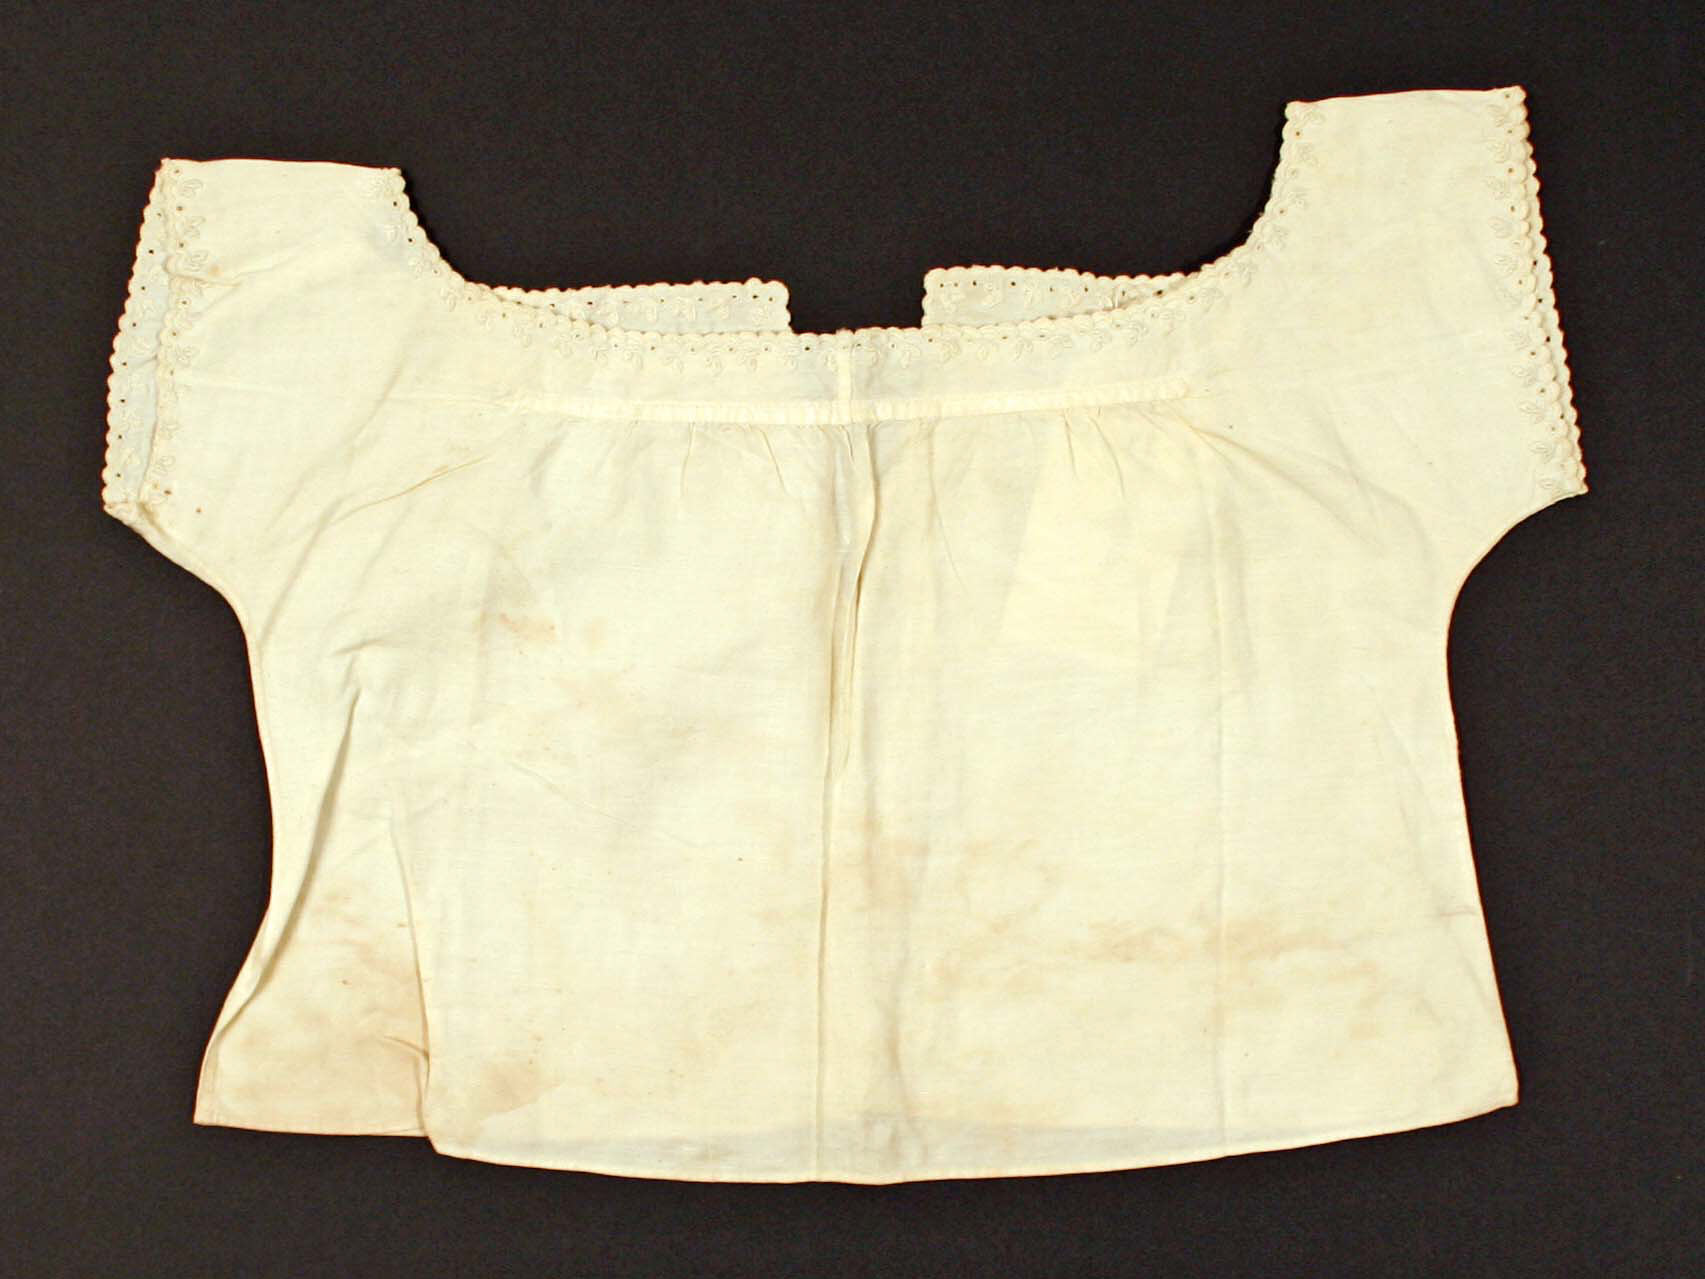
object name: shirt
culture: american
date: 1834-1866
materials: linen